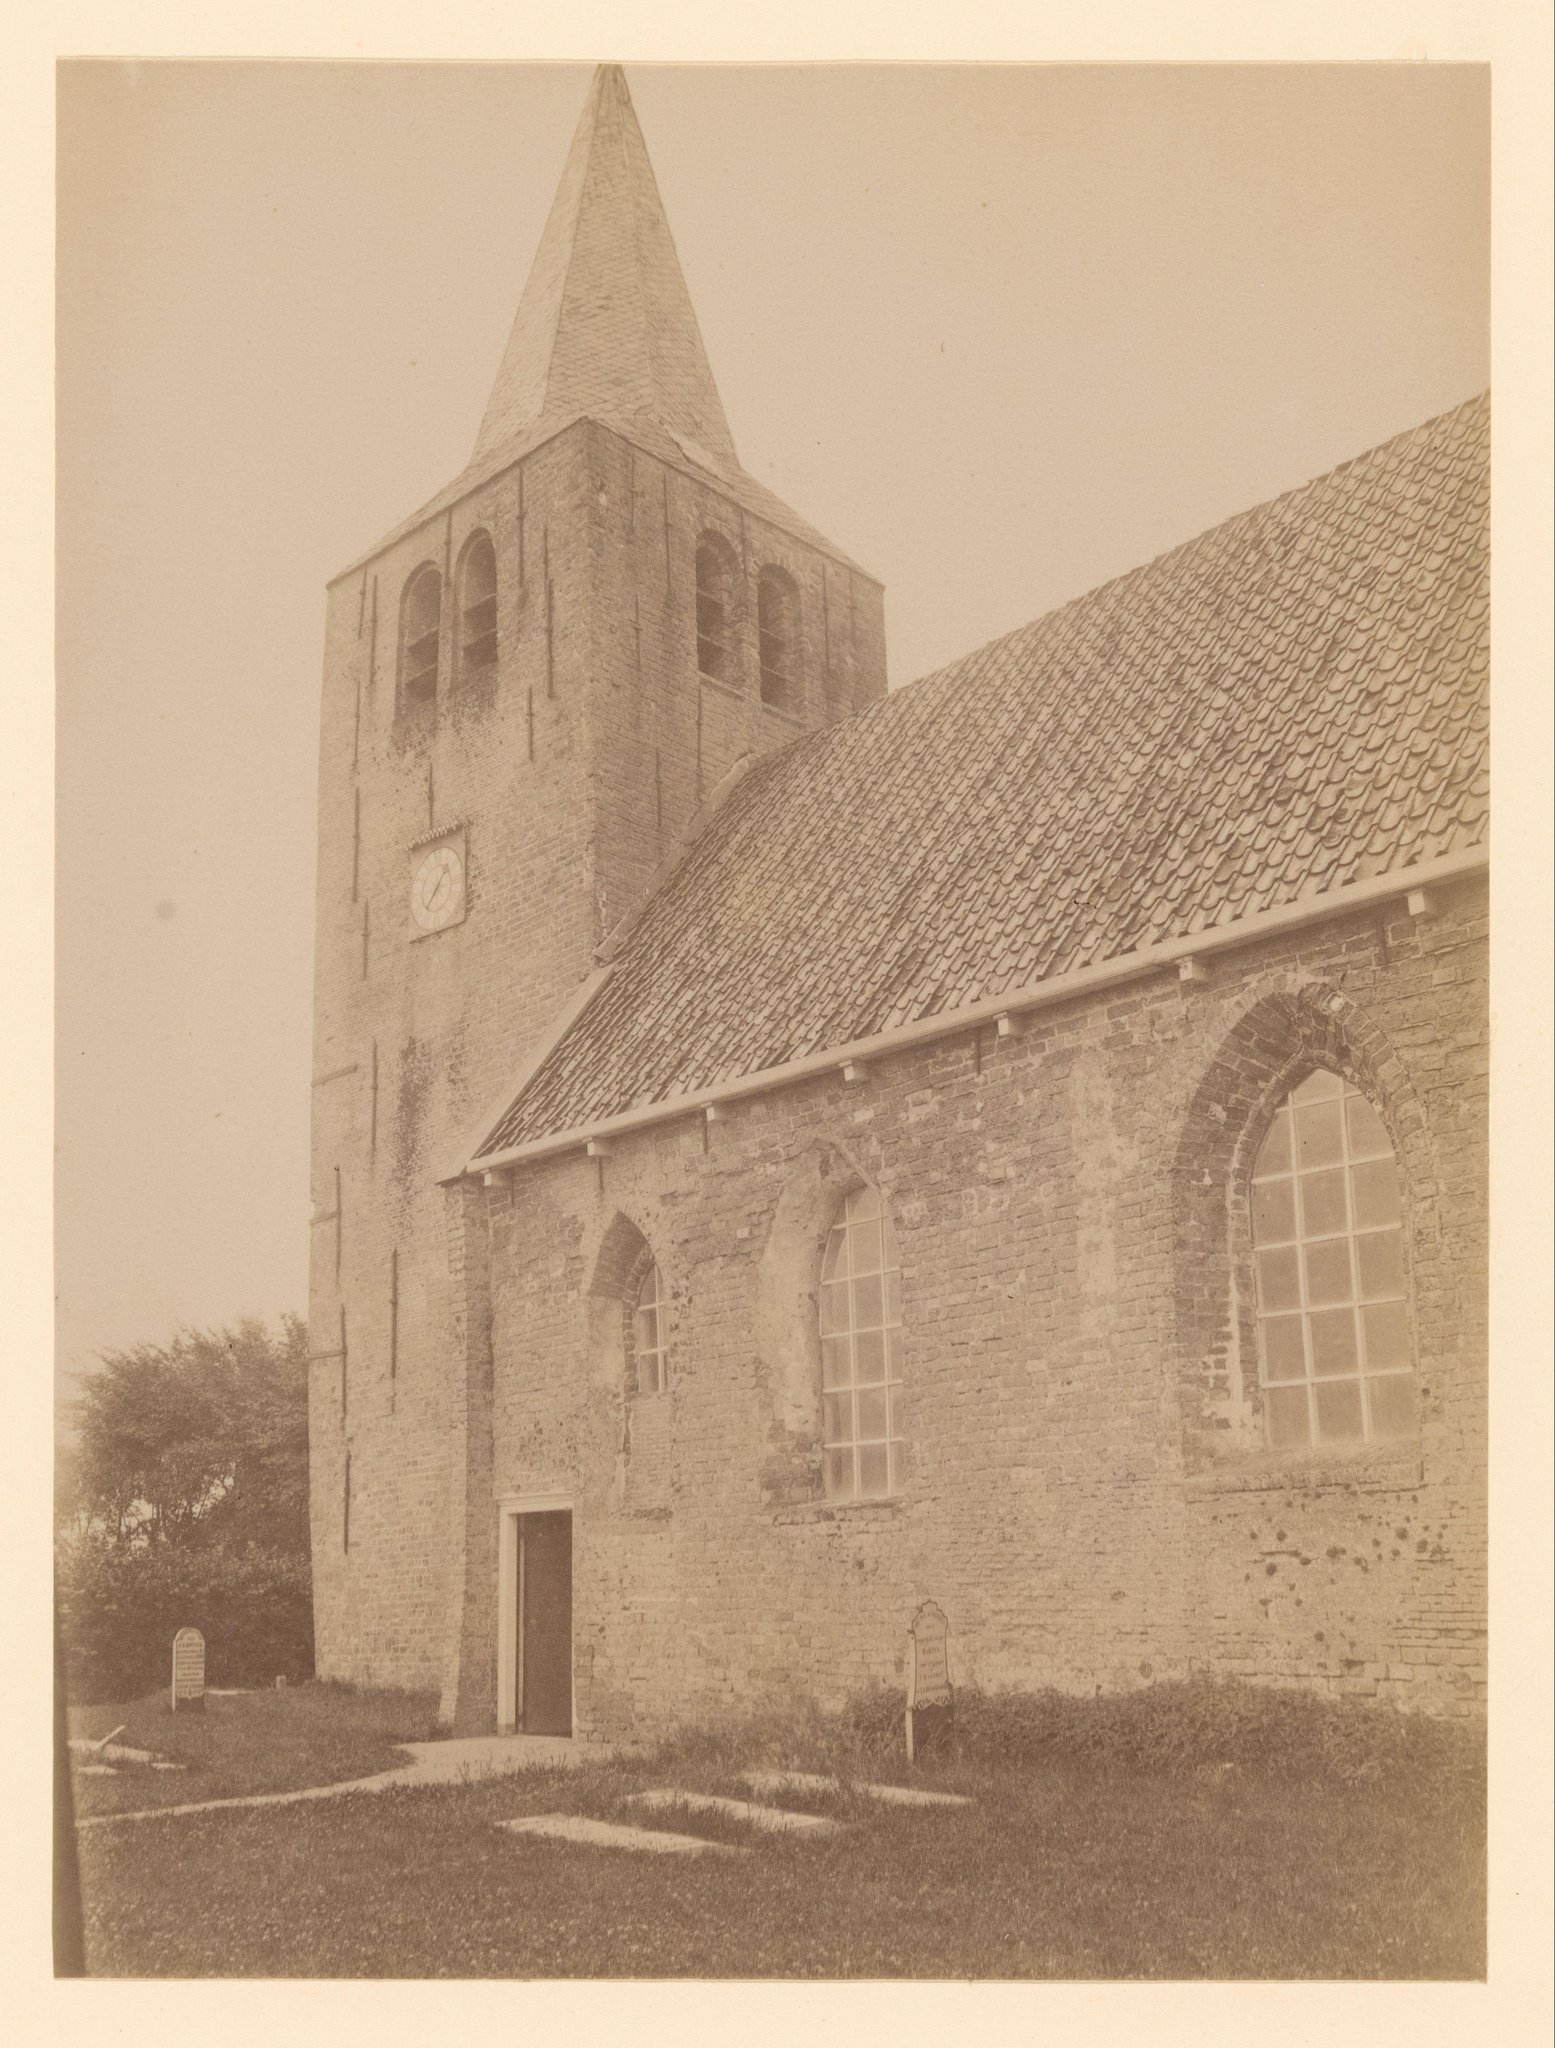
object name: photograph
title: Toren van de voormalige Hervormde Kerk te Oosterwierum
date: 1902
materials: cardboard, photographic support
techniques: albumen print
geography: oosterwierum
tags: parts of church exterior and annexes: tower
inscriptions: annotation: ‘Oosterwierum / Toren a/d N.H. Kerk / Aug 1902 / Baarderadeel’, annotation: ‘Oosterwierum/ Oosterwierum/ gem. Baarderadeel’